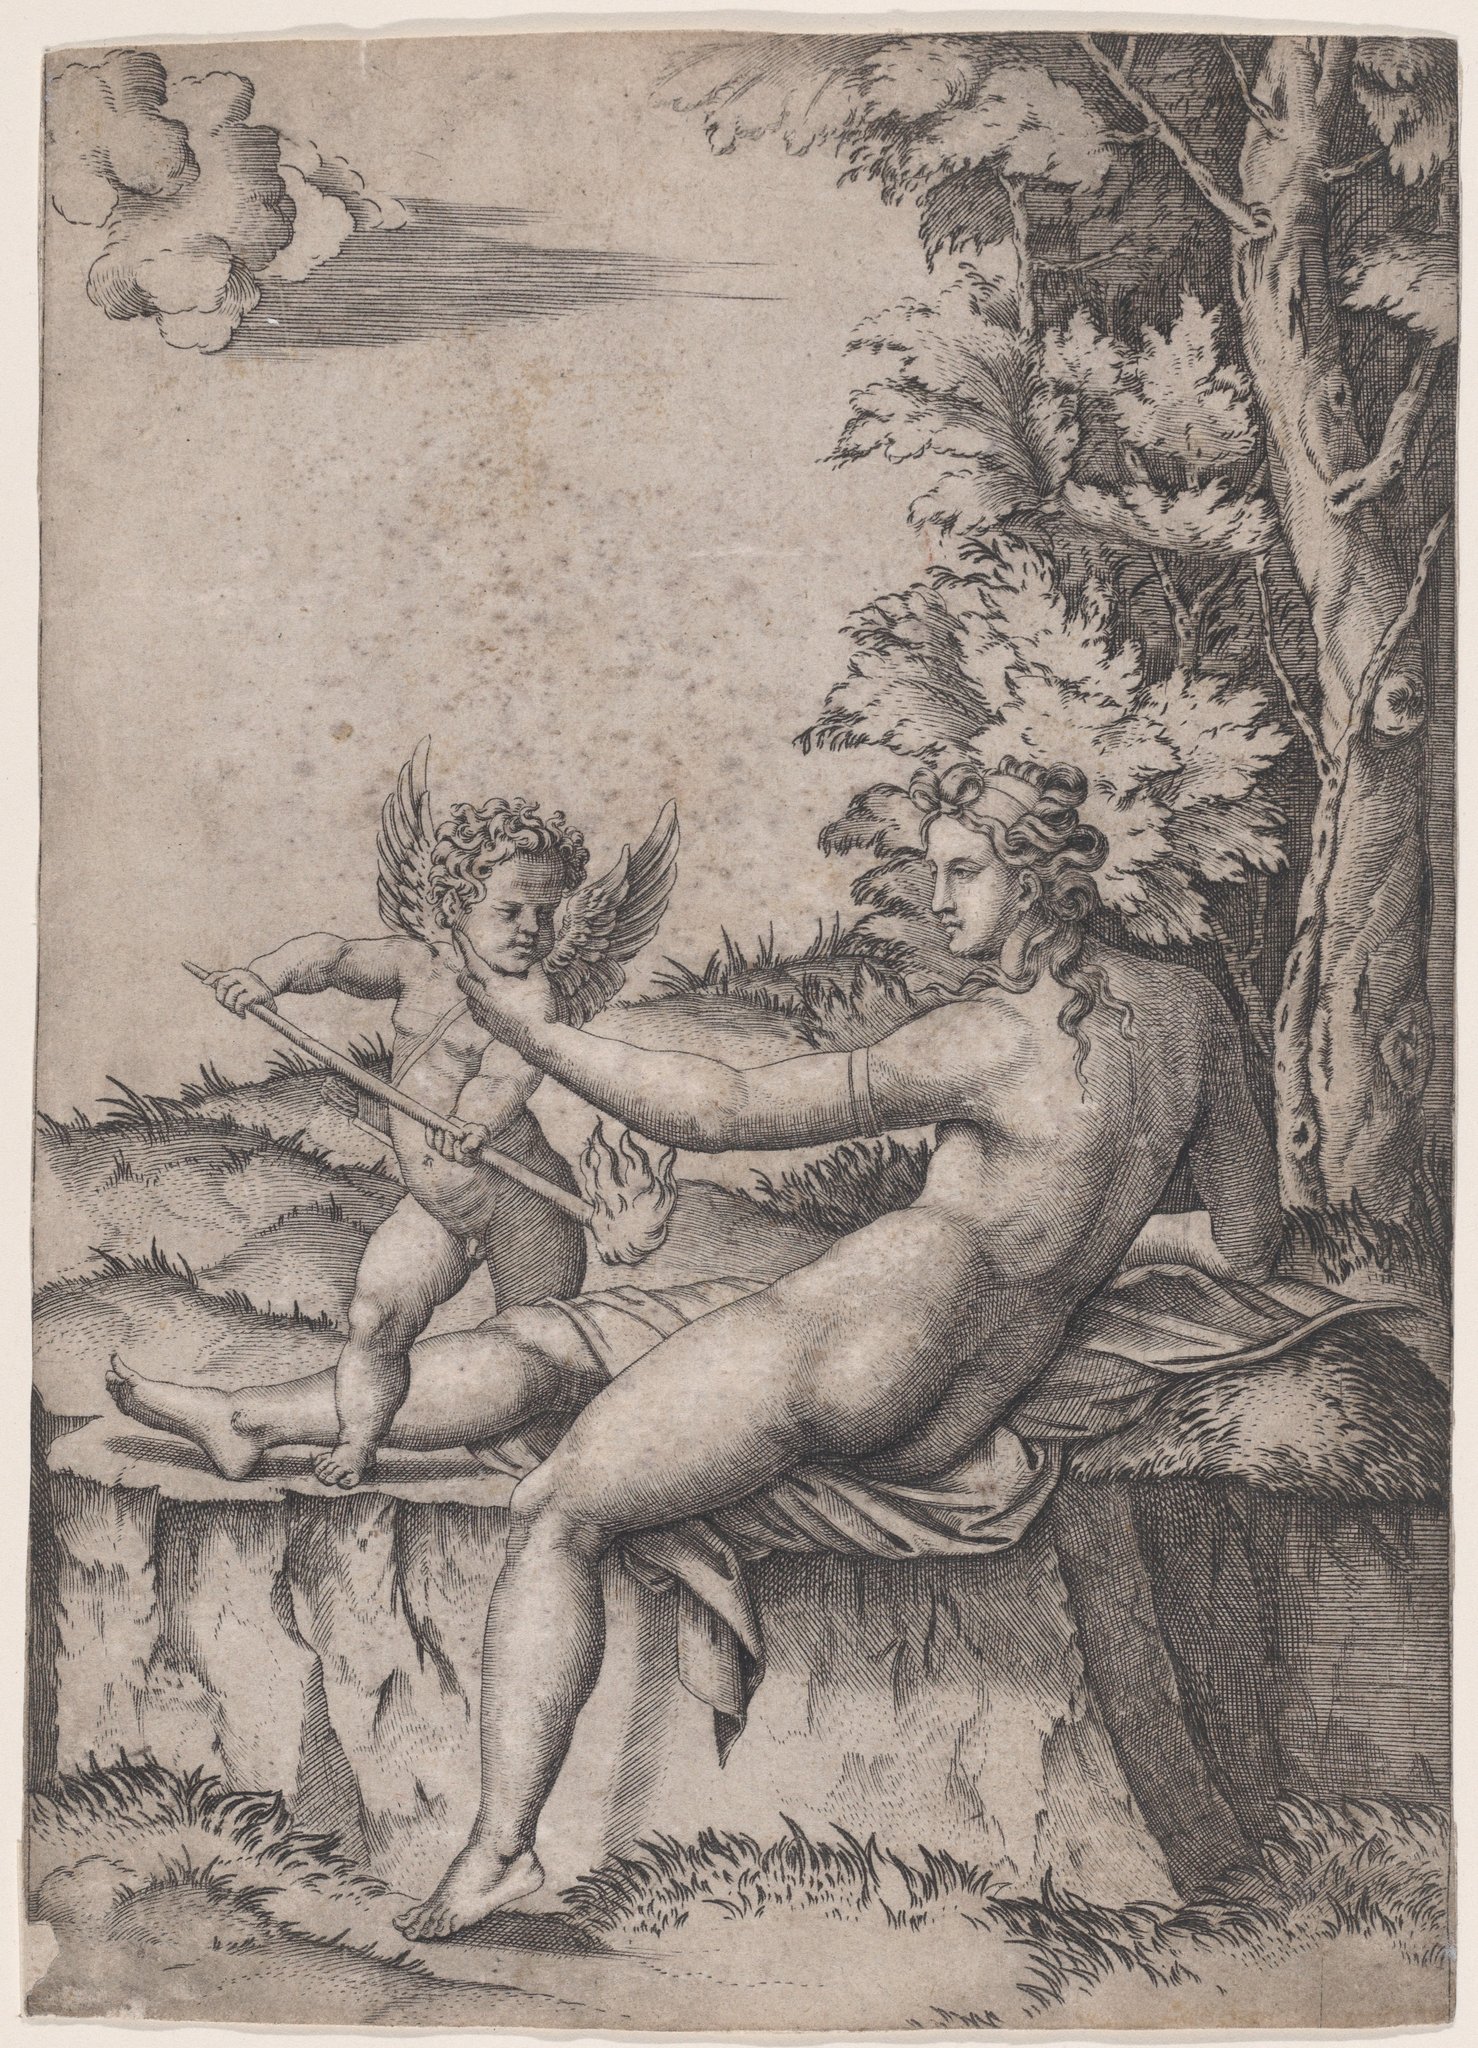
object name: print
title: Venus and Eros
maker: agostino veneziano (agostino dei musi)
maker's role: artist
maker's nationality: italian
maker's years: 1490-1536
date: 1514-1536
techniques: engraving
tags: female nudes,cupid,venus